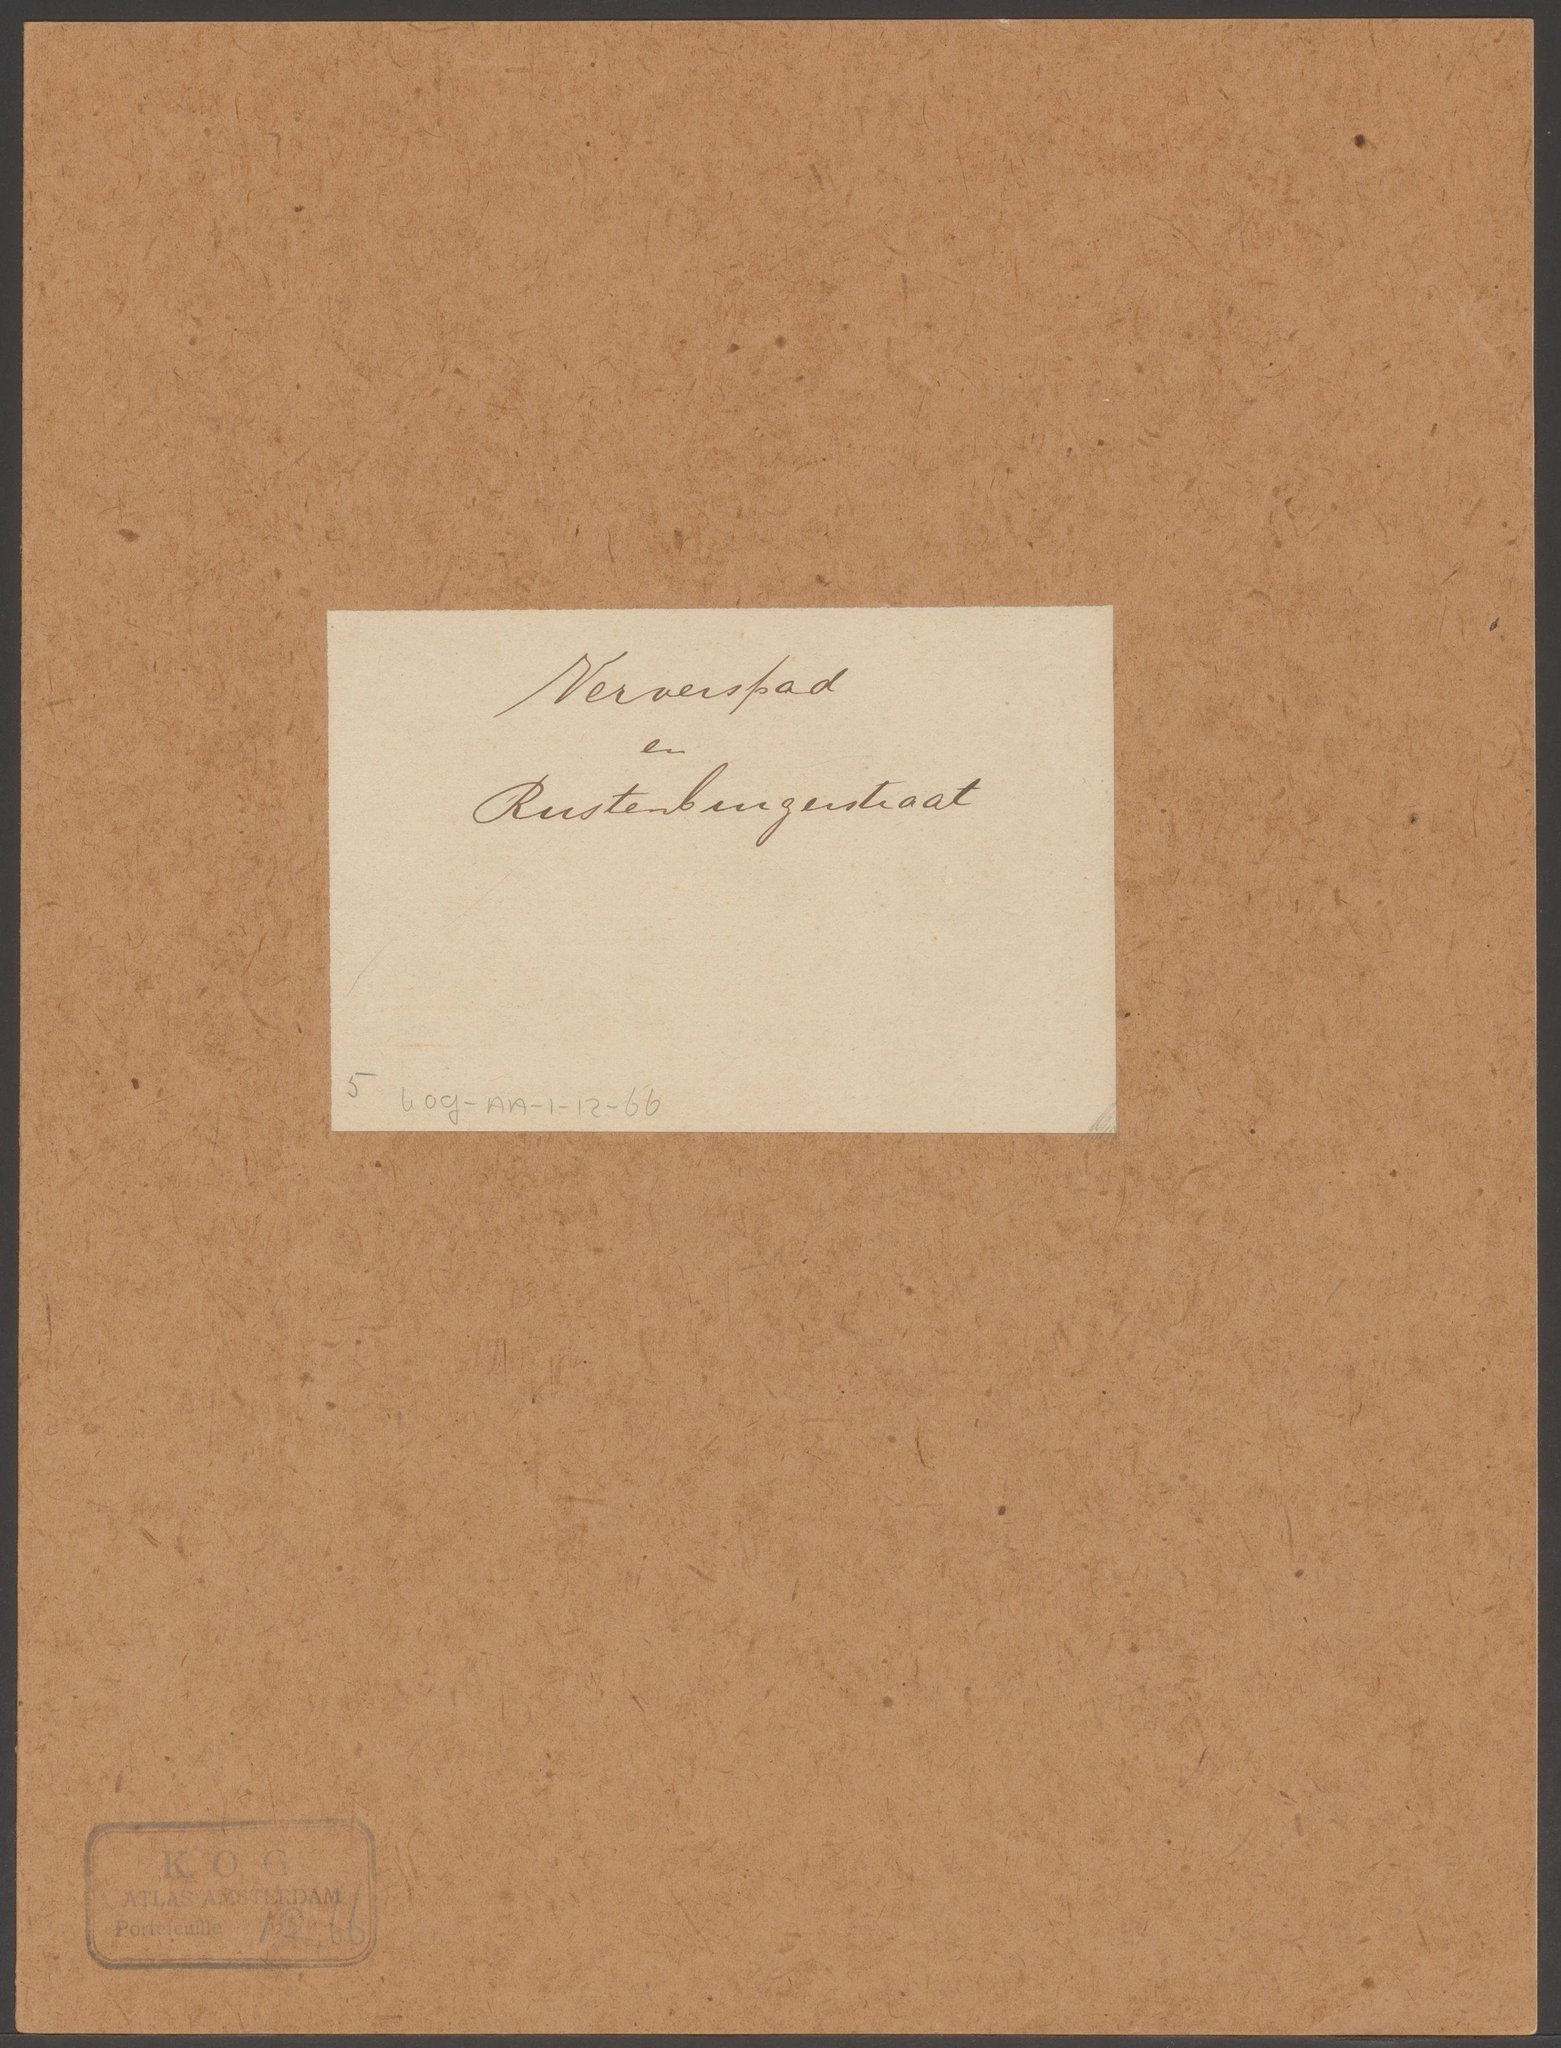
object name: photomechanical print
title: Gezichten op het Ververspad en de Rustenburgerstraat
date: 1907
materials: paper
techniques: letterpress printing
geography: amsterdam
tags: city-view in general; 'veduta', road, path, winter landscape; landscape symbolizing winter (the four seasons of the year)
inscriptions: date: ‘9. Febr:1907.’, inscription: ‘Ververspad / en / Rustenburgerstraat’, collector's mark: ‘12,66’ Lugt 1641b, name: ‘P.C. Brandt’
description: Onderwerpsrubriek binnen de Atlas Amsterdam: Rokin, Rotterdammersloot, Rozengang, Rozengracht, Rozenstraat, Rusland, Rustenburgerstraat, Ruysdaelkade, Ruysdaelstraat, Ruyterkade (de), Ruyterweg (Admiraal de). Drie bladzijden met gezichten op en teksten over het Ververspad en de Rustenburgerstraat.